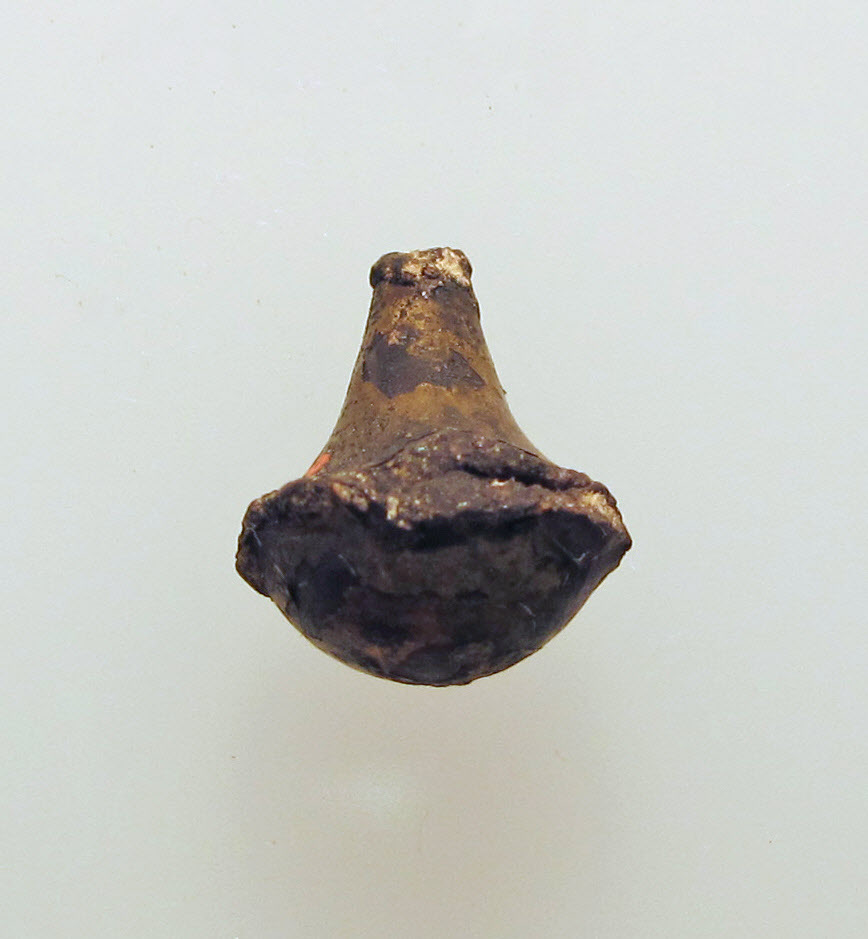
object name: pendant, nail head, from earring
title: Pendants, nail head, from earrings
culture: cypriot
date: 3900 BCE-100 CE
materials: silver